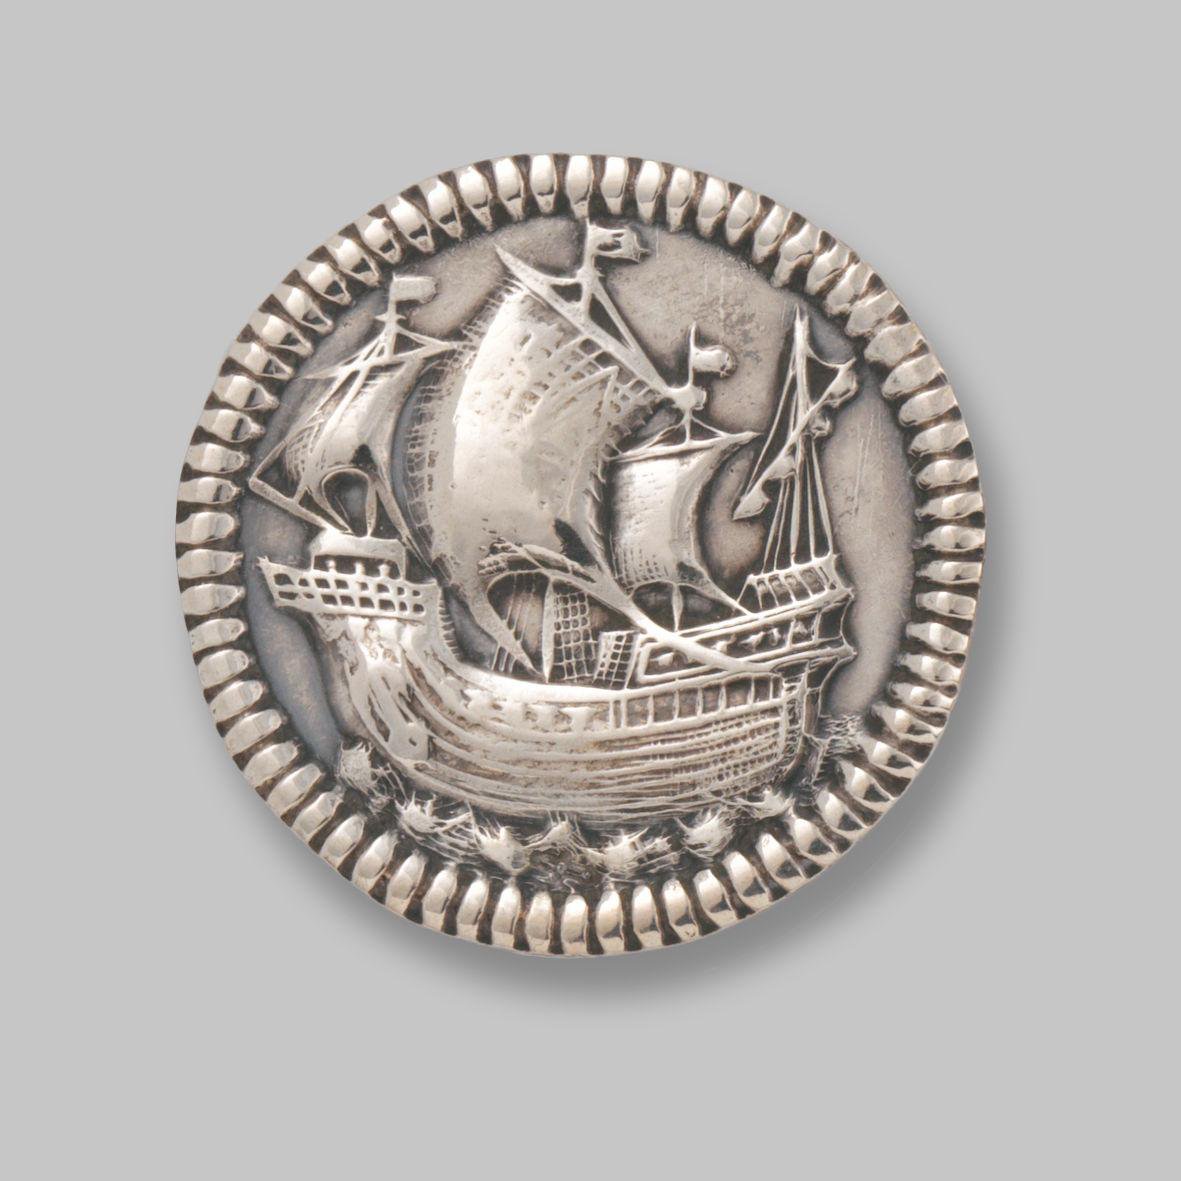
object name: button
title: Knoop met voorstelling van een driemaster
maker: Anonymous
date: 1850-1900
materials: silver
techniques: casting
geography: netherlands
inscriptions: alloy mark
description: Knoop van gegoten zilver, rond, met op de voorzijde een driemaster omgeven door een geribde rand. Aan de achterzijde is een uit gebogen draad vervaardigd oog bevestigd.